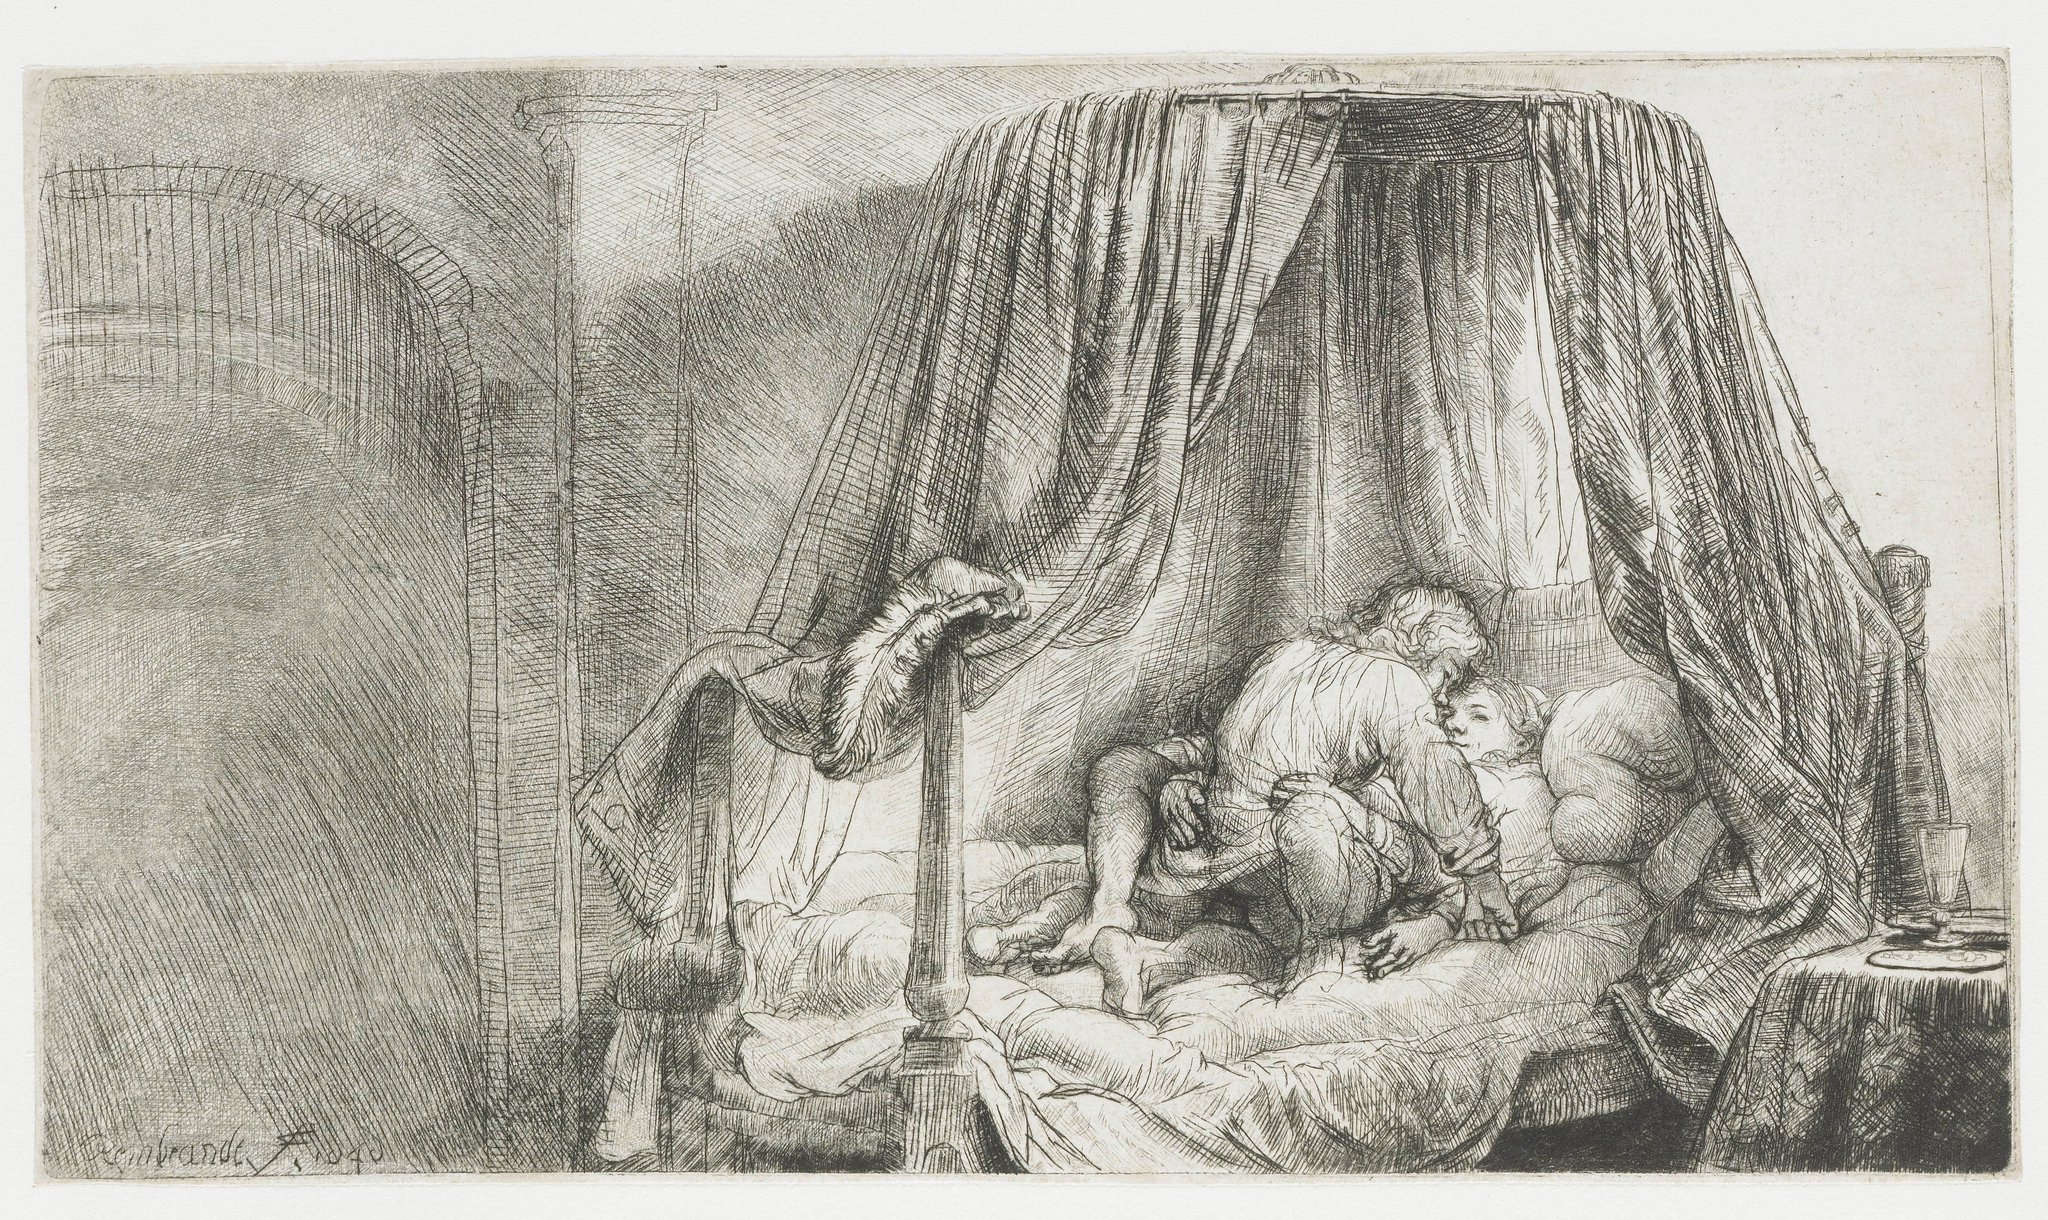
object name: print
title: The French bed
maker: rembrandt van rijn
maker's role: draughtsman, painter, print maker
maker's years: 1606-1669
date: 1646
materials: paper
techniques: drypoint, etching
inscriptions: mark: Lugt 2228, signature and date: ‘Rembrandt f. 1646’, mark: Lugt 972, inscription: ‘onleesbaar’ 17e-eeuws?